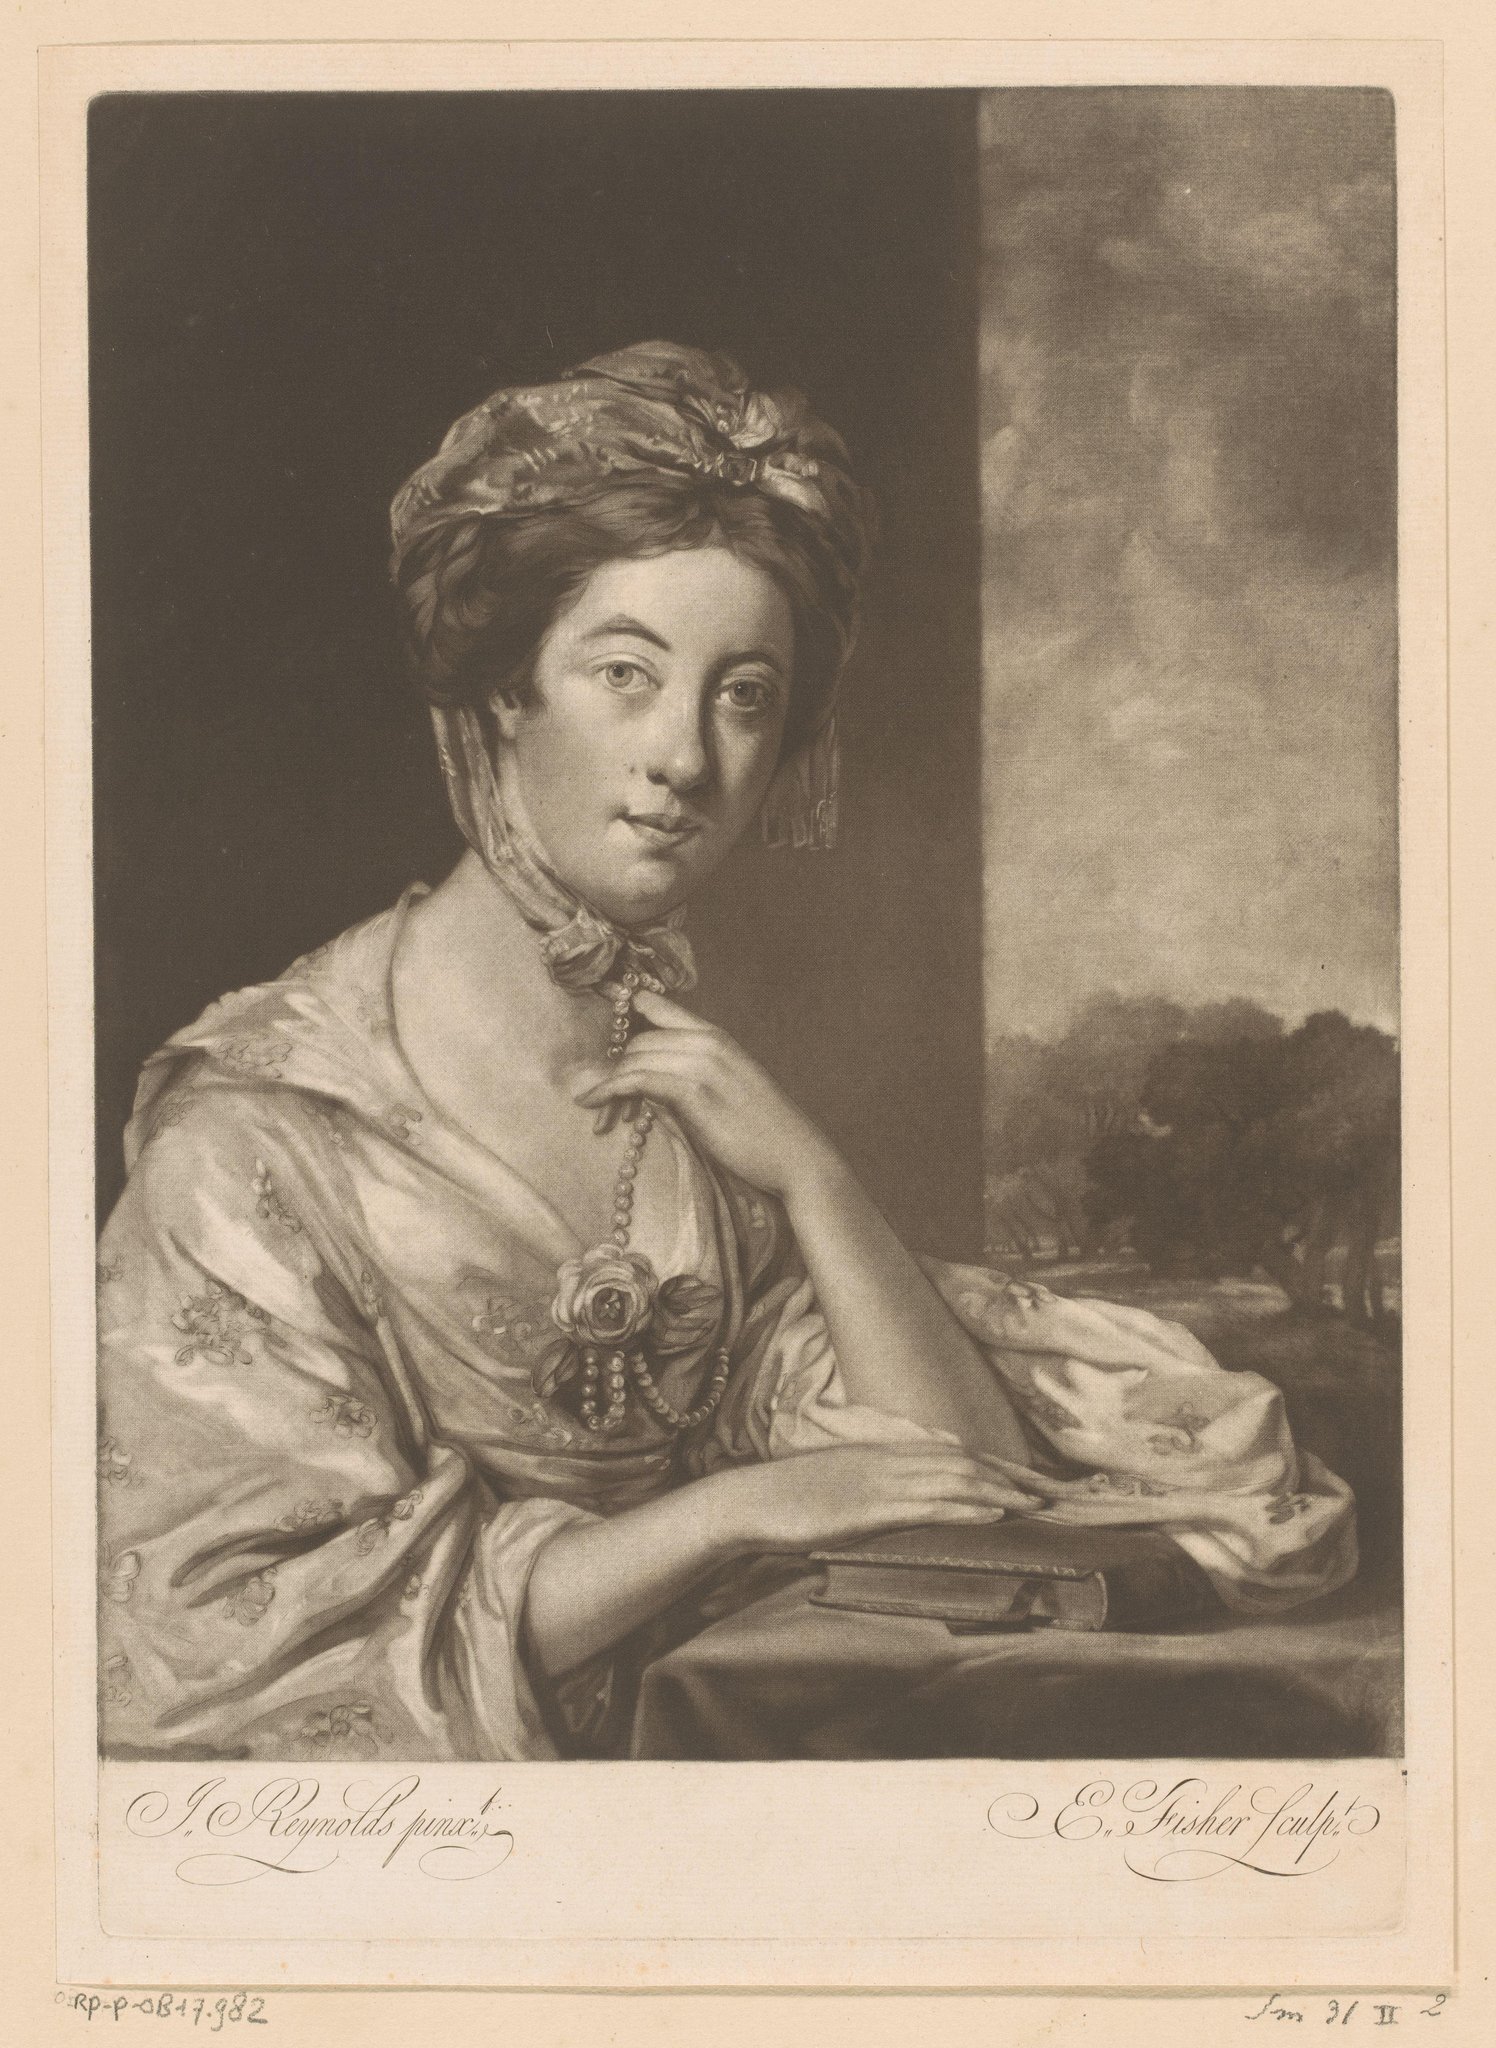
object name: print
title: Portret van Mary Hope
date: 1767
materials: paper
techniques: mezzotint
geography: london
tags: historical persons - bb - woman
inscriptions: collector's mark: Lugt 240